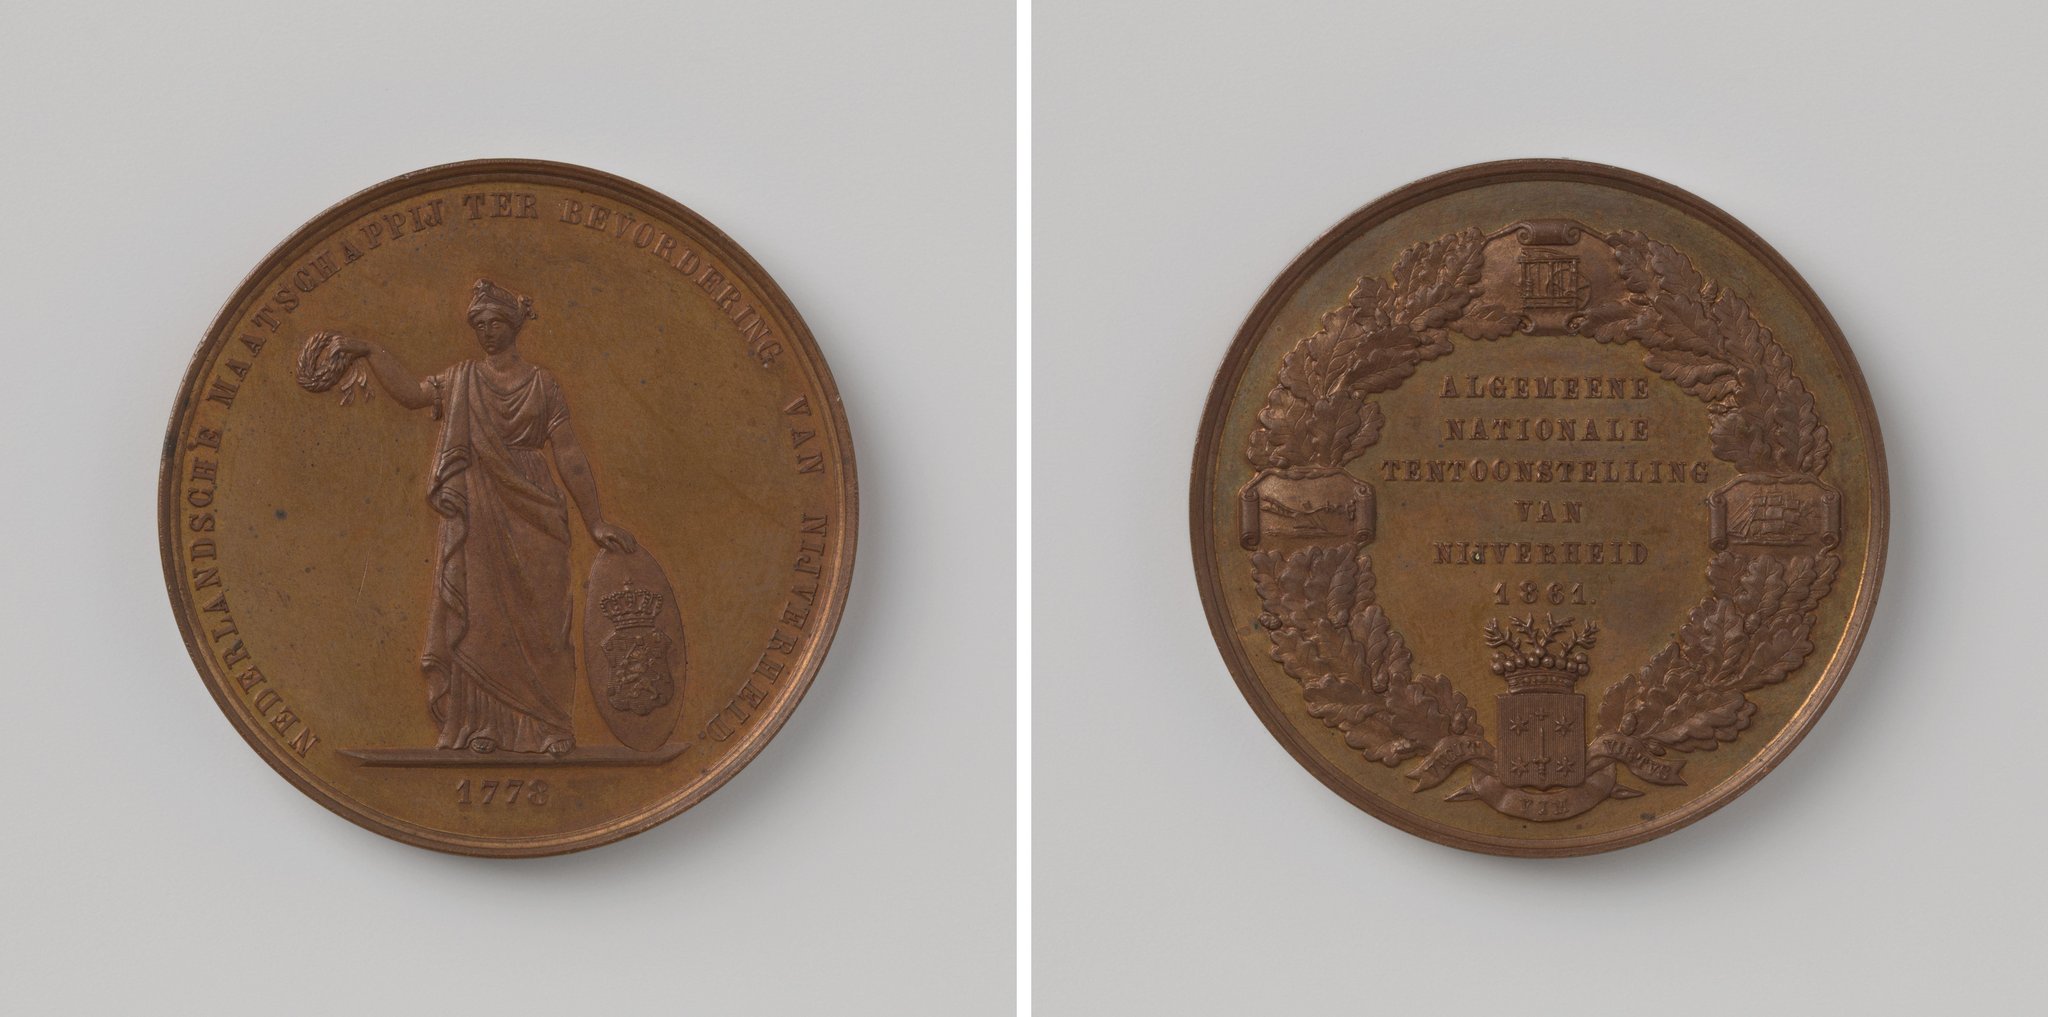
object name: history medal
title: Algemeene Nationale tentoonstelling van Nijverheid te Haarlem, georganiseerd door de Maatschappij ter bevordering van Nijverheid, voorheen de Oeconomische Tak van de Hollandsche Maatschappij der Weten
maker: david van der kellen (1804-1879)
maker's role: die cutter, draughtsman, print maker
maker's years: 1804-1879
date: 1861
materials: silver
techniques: striking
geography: utrecht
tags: haarlem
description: Zilveren penning. Voorzijde: vrouw in Romeinse kledij met diadeem op hoofd, voorstellende Nijverheid, houdt in haar uitgestrekte rechterhand een lauwerkrans en rust met haar andere hand op een wapenschild binnen omschrift; afsnede: jaartal en signatuur. Keerzijde: opschrift boven gekroond wapenschild binnen eikekrans, waaraan drie cartouches zijn bevestigd met daarin een ploeg, een driemaster en een stoommachine